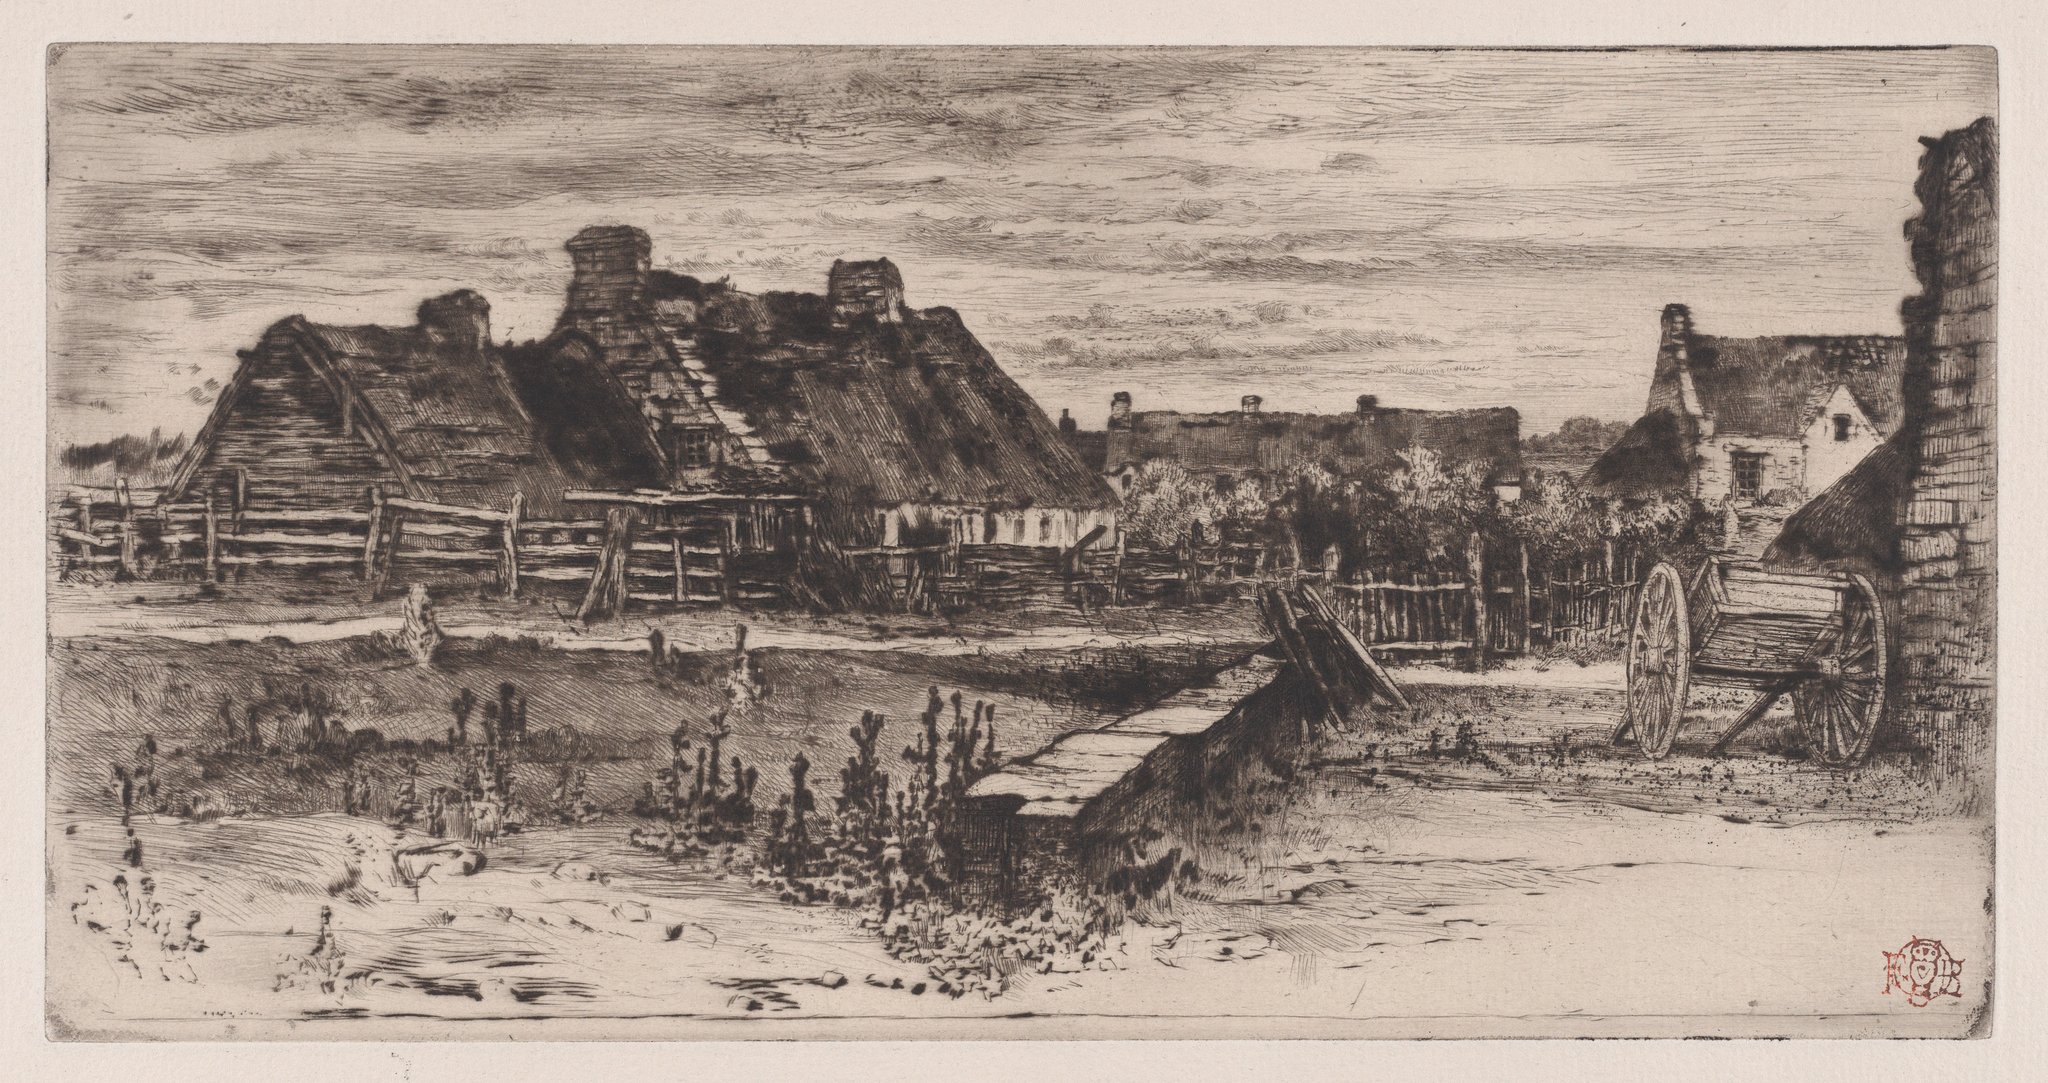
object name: print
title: Large Thatched Cottages (Les Grandes Chaumières)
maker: félix-hilaire buhot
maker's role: artist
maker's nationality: french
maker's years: 1847-1898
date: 1860-1898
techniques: aquatint, drypoint, etching, roulette